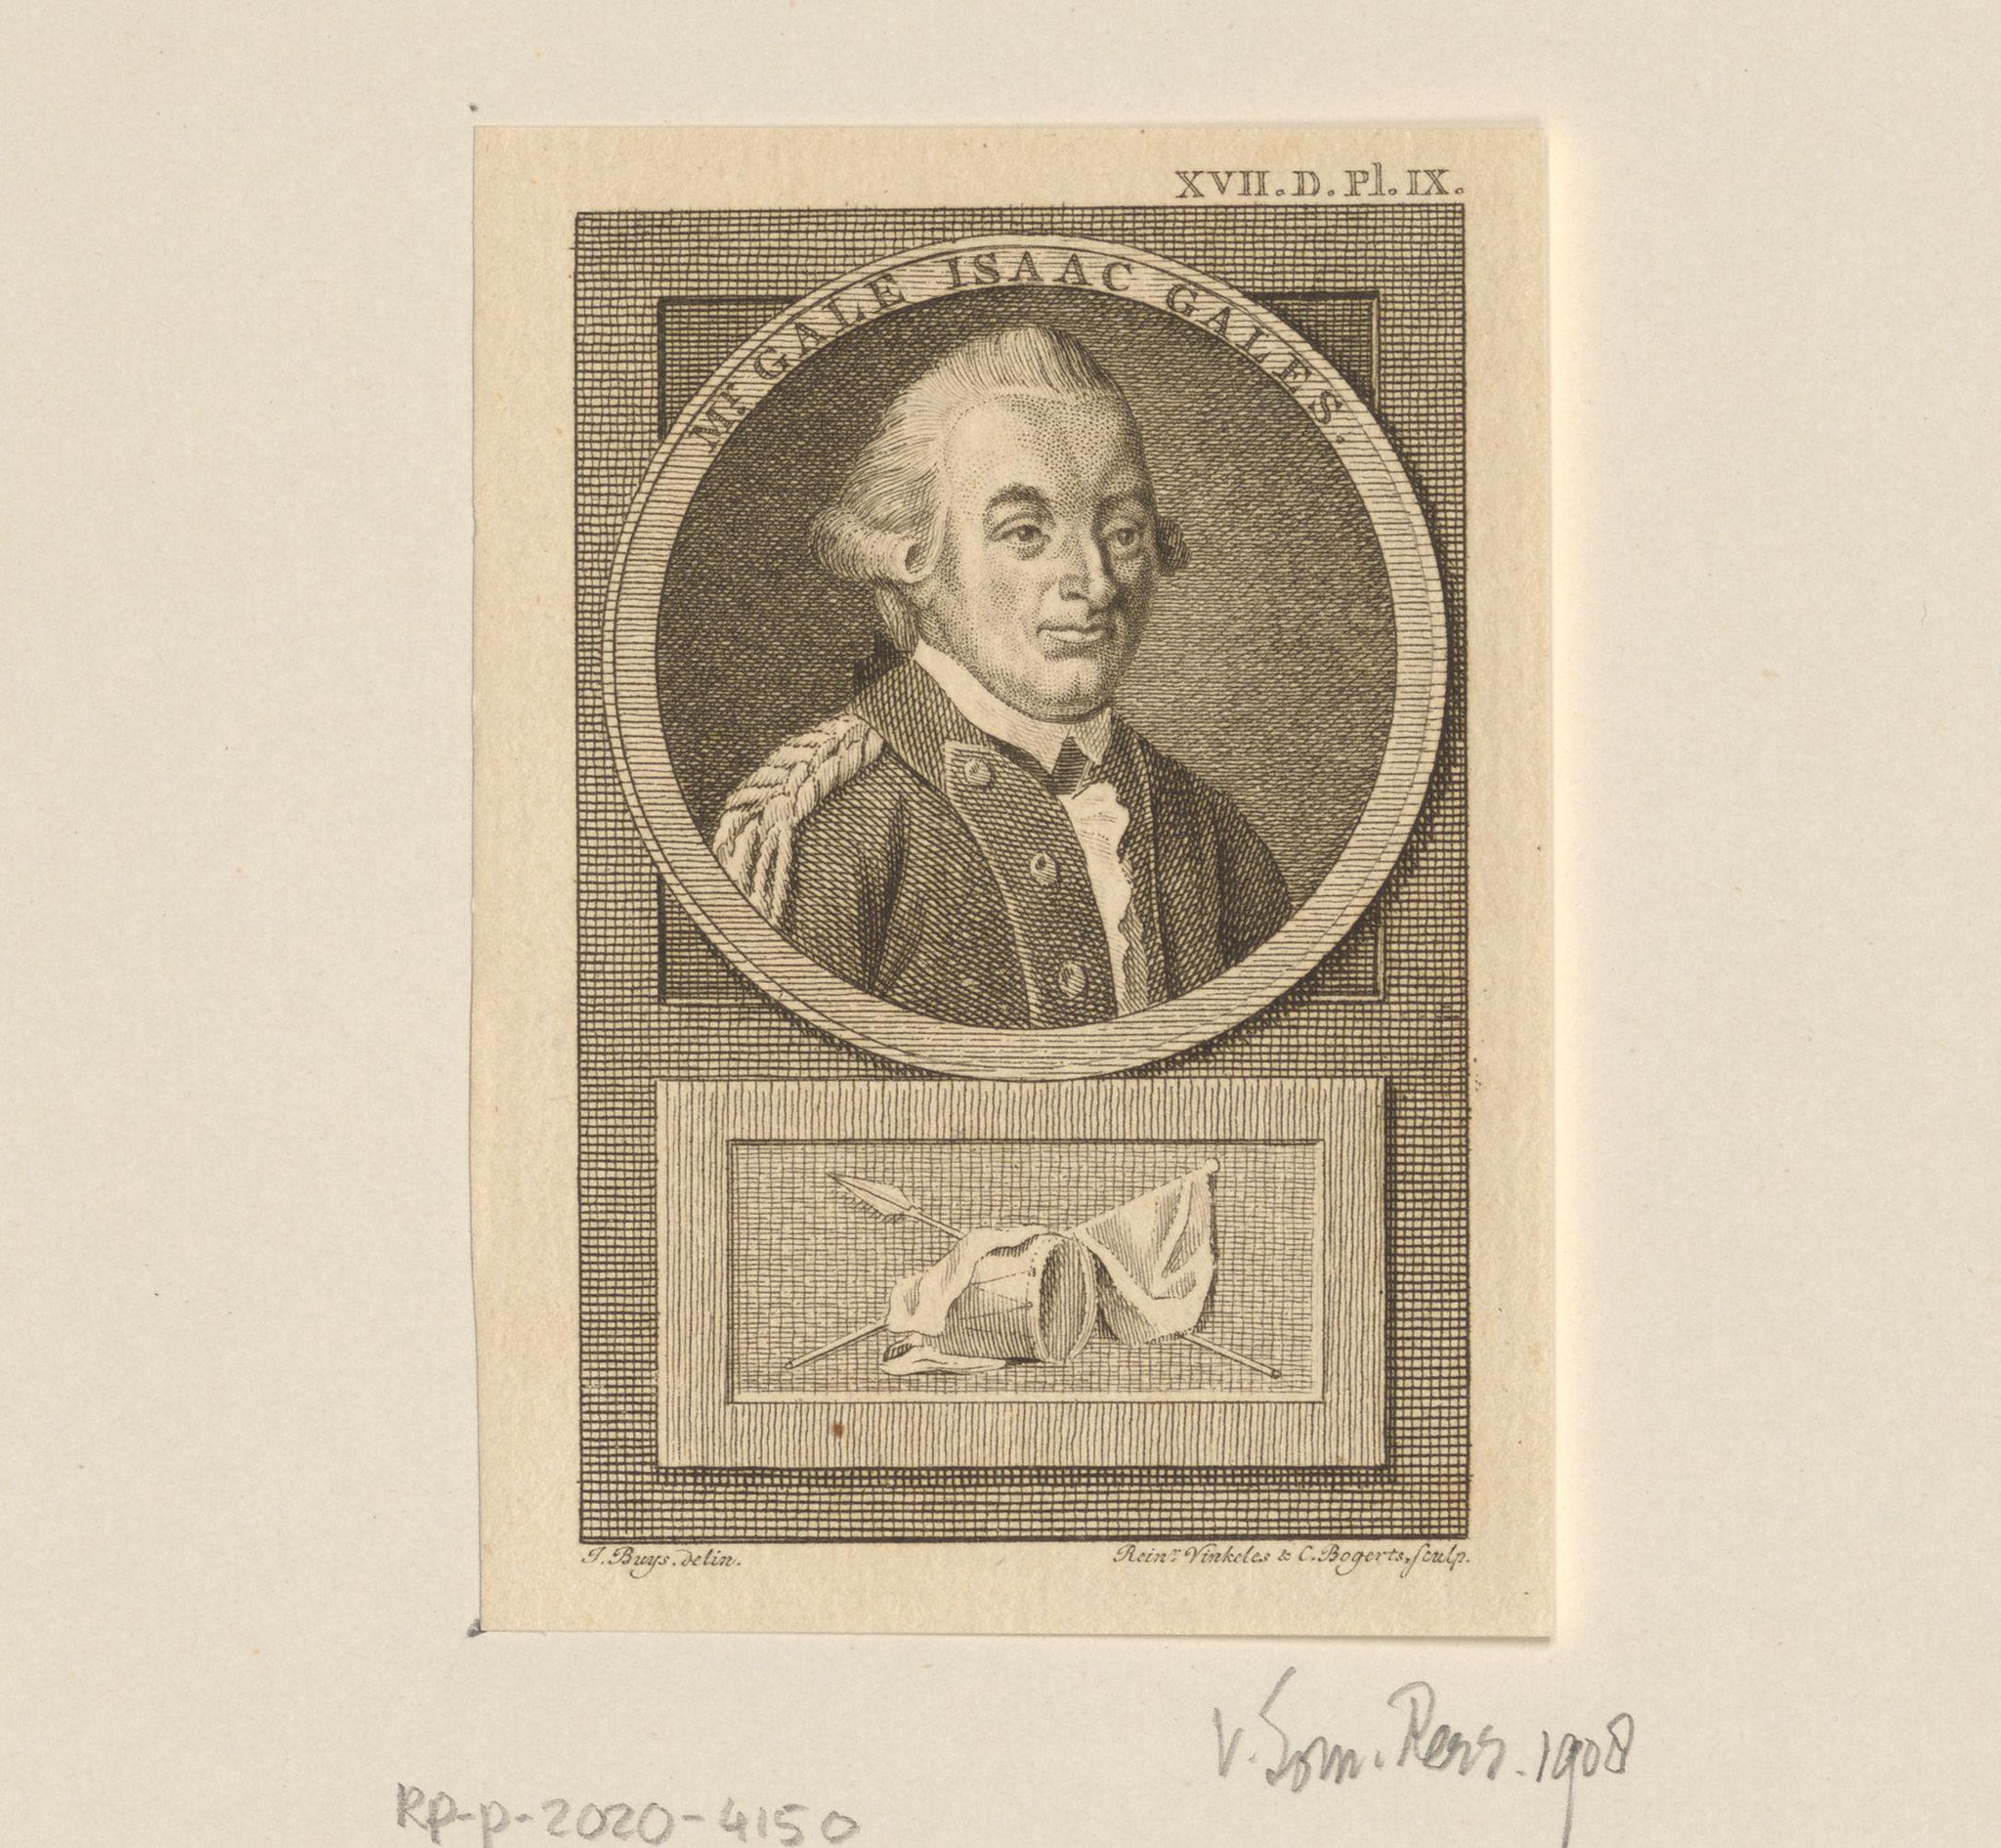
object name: print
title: Portret van Gale Isaac Gales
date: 1783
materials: paper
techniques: engraving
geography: amsterdam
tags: theologian, historical persons, professor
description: Latere staat van prent mogelijk gebruikt in: Fokke, Jan. Geschiedenissen der Vereenigde Nederlanden voor de vaderlandsche jeugd Ie-XXVste deel. Amsterdam: Johannes Allart, 1783-1795.